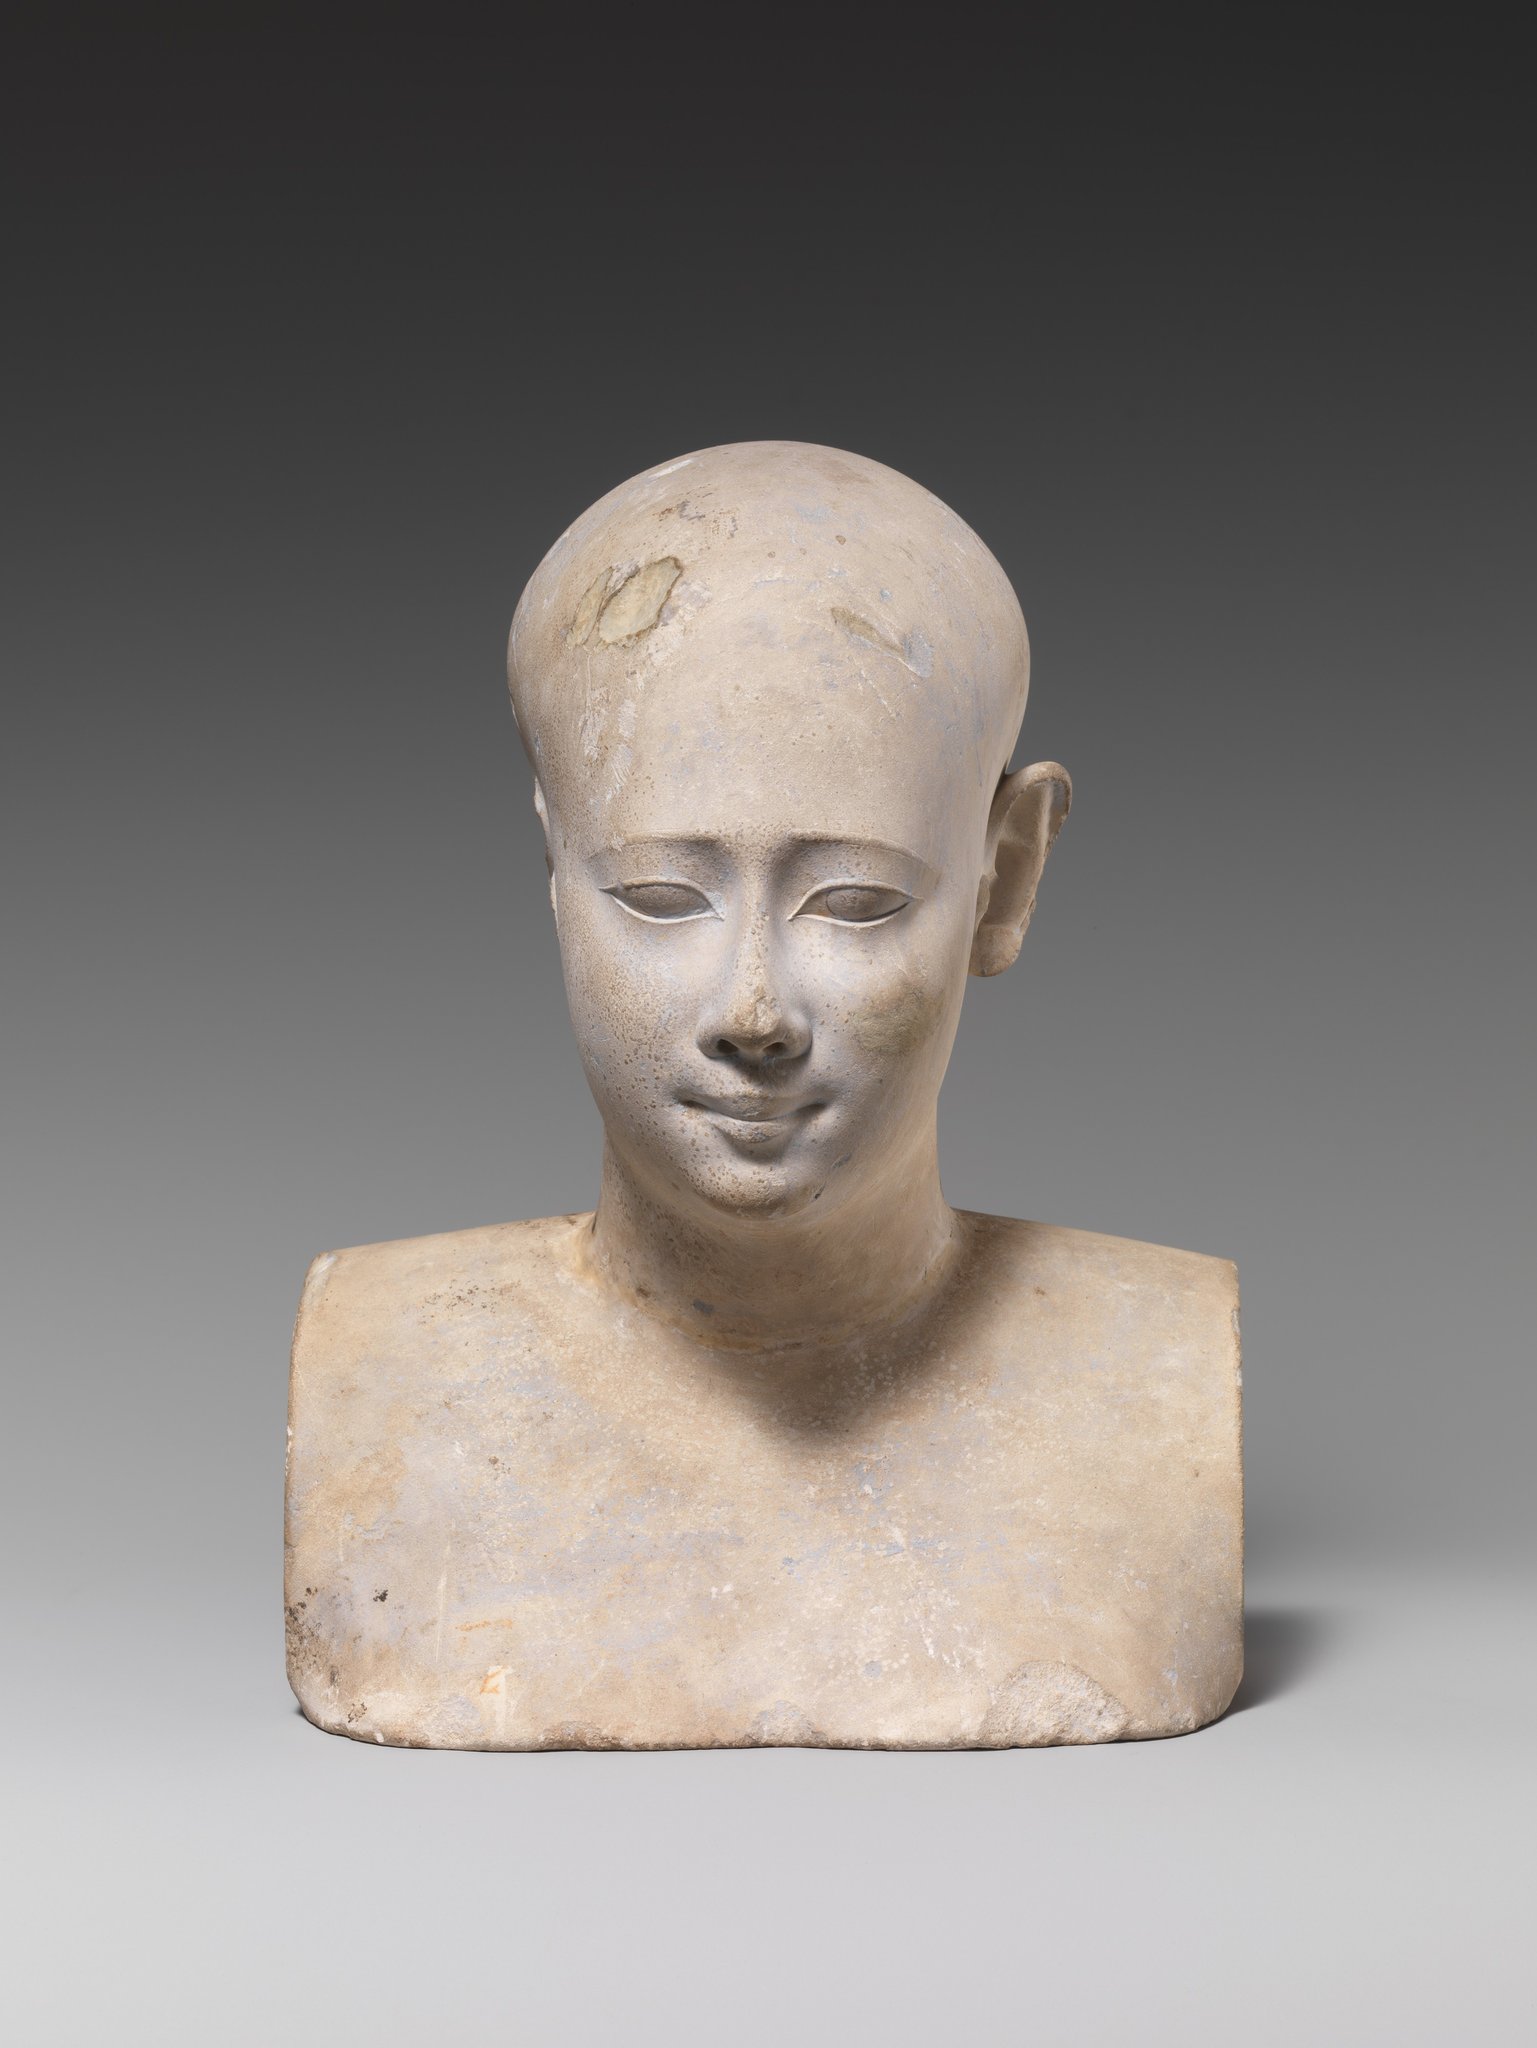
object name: sculptor's model votive, bust of a bald or shaven man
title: Bust of a priestly figure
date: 400-200 BCE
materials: limestone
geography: egypt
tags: men,portraits